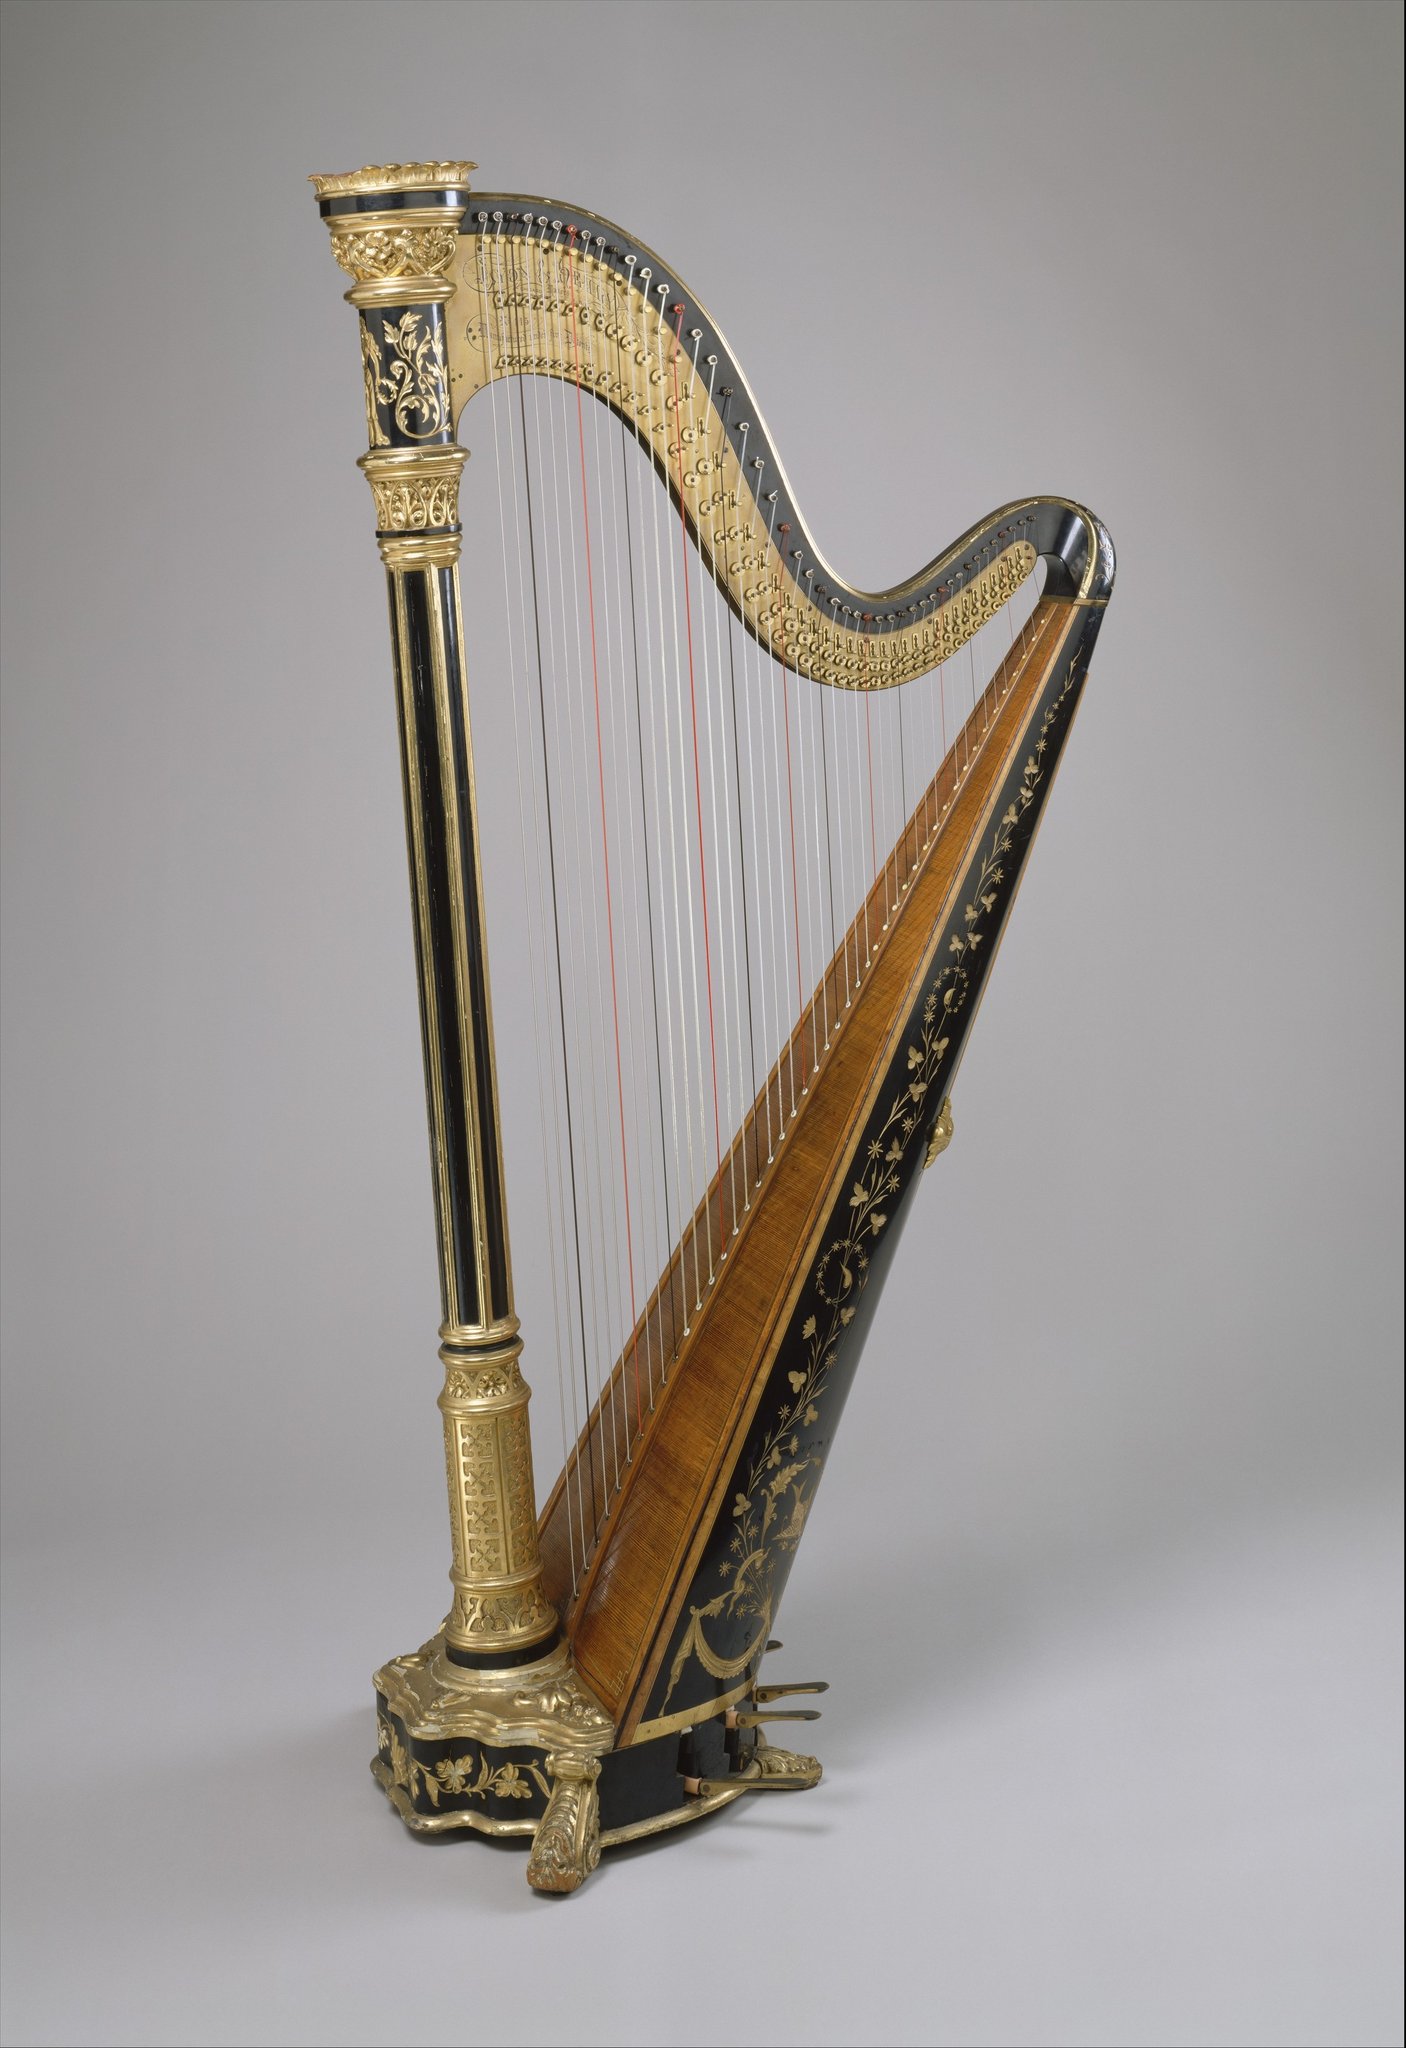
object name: pedal harp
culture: american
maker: lyon & healy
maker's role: maker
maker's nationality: american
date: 1891-1895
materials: metal, wood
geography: united states